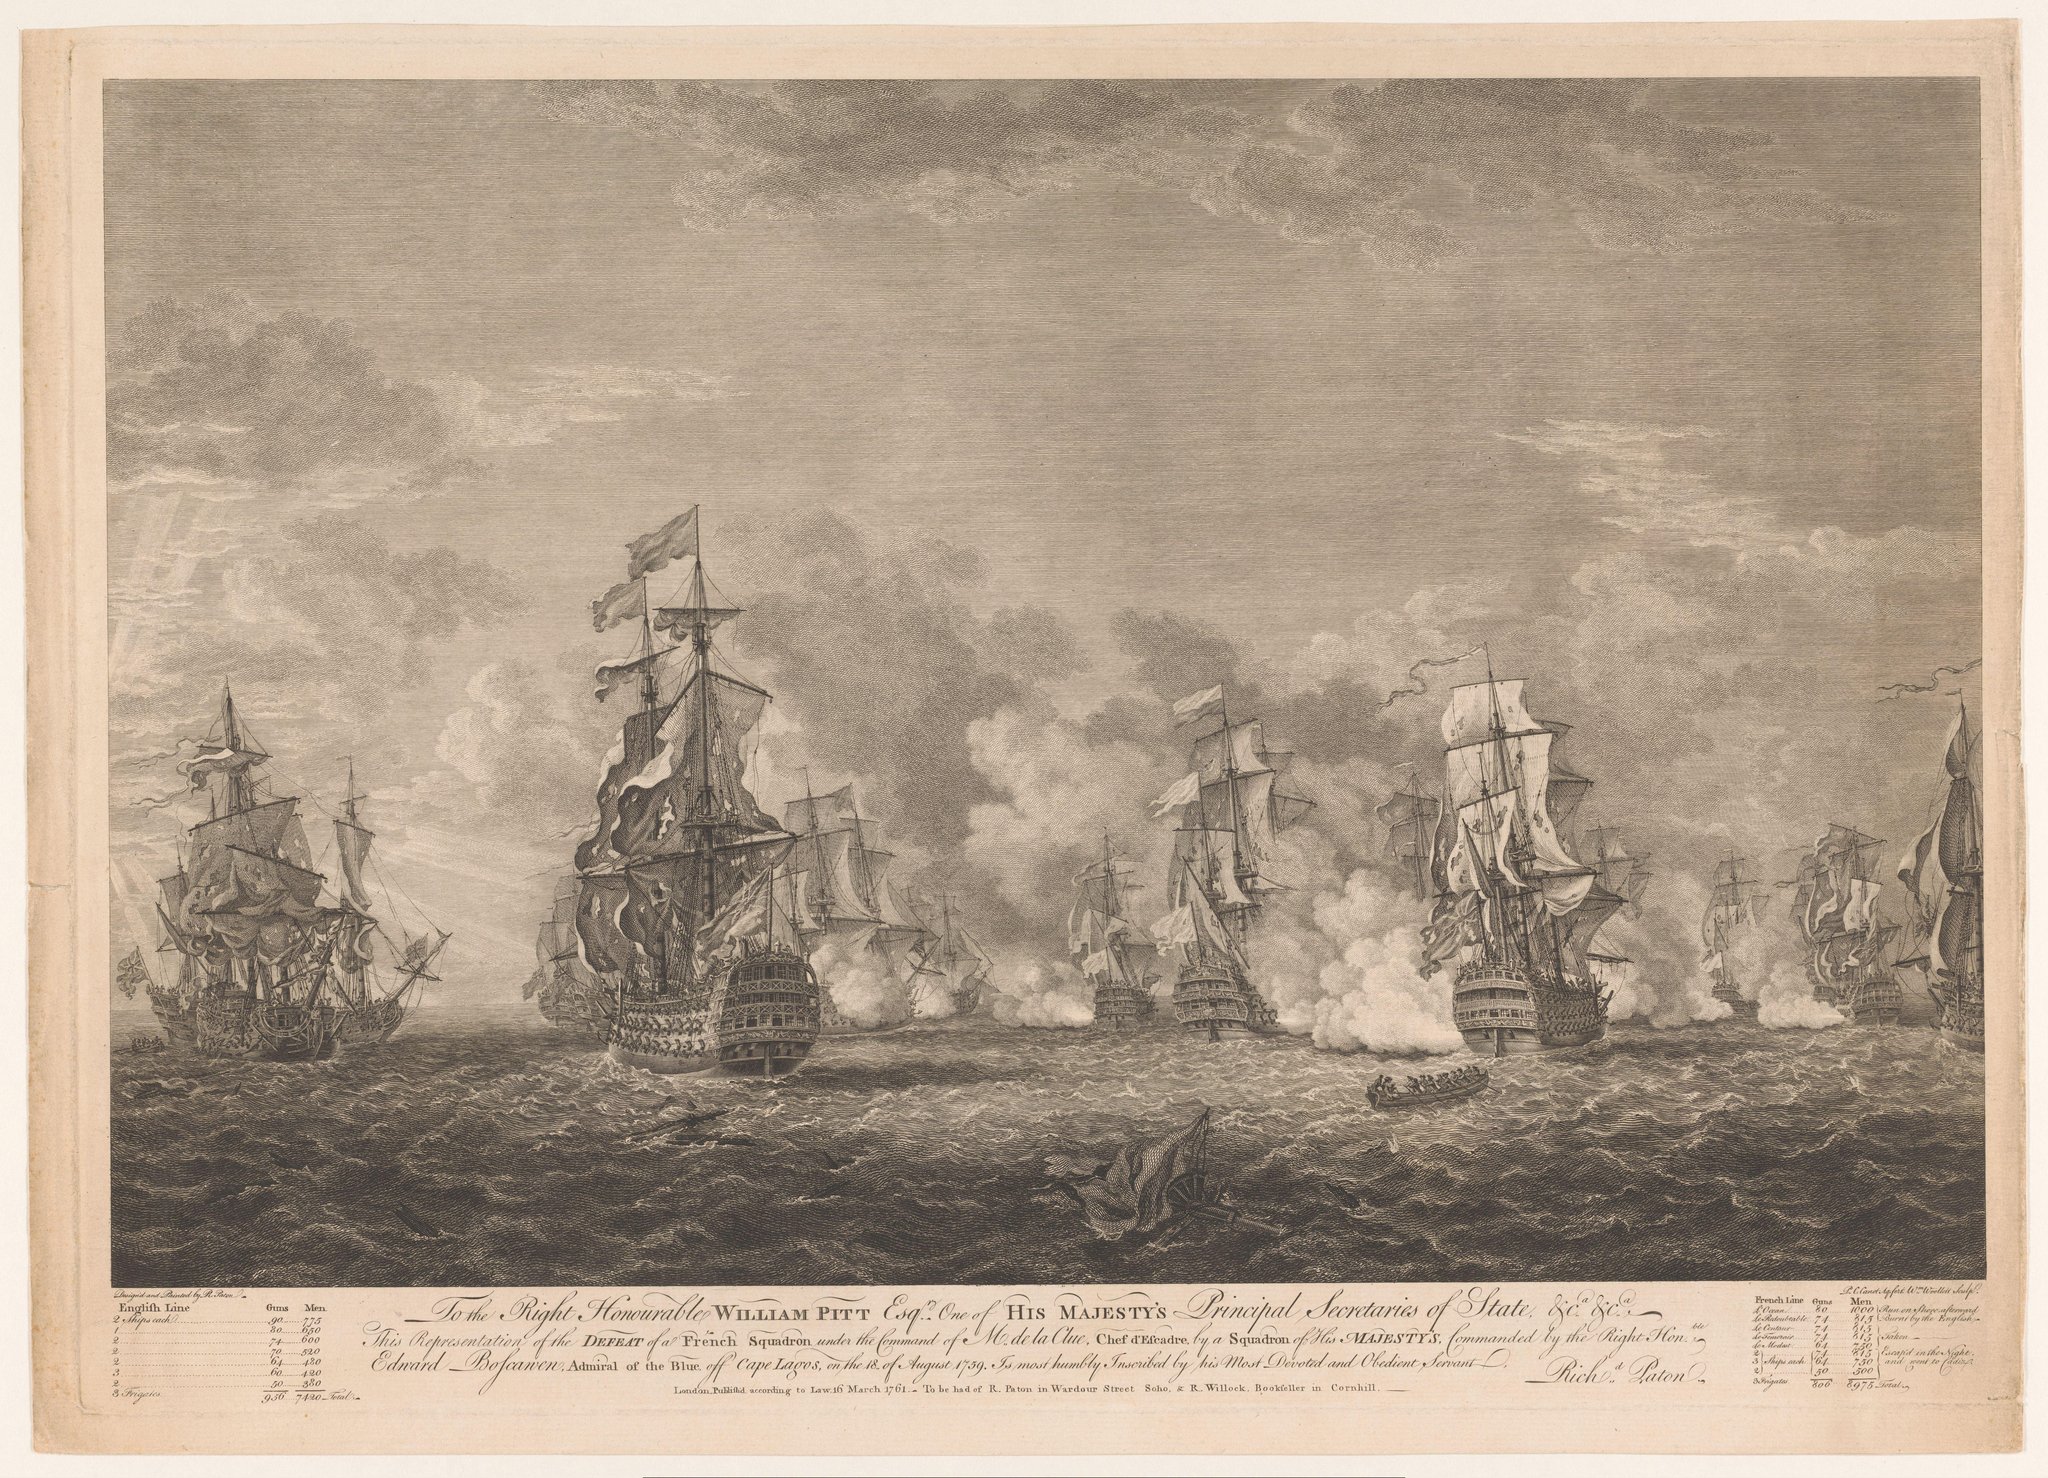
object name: print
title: Slag bij Lagos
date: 1761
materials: paper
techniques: etching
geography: london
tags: battle (+ naval force), victory ~ armed conflict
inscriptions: collector's mark: Lugt 2228